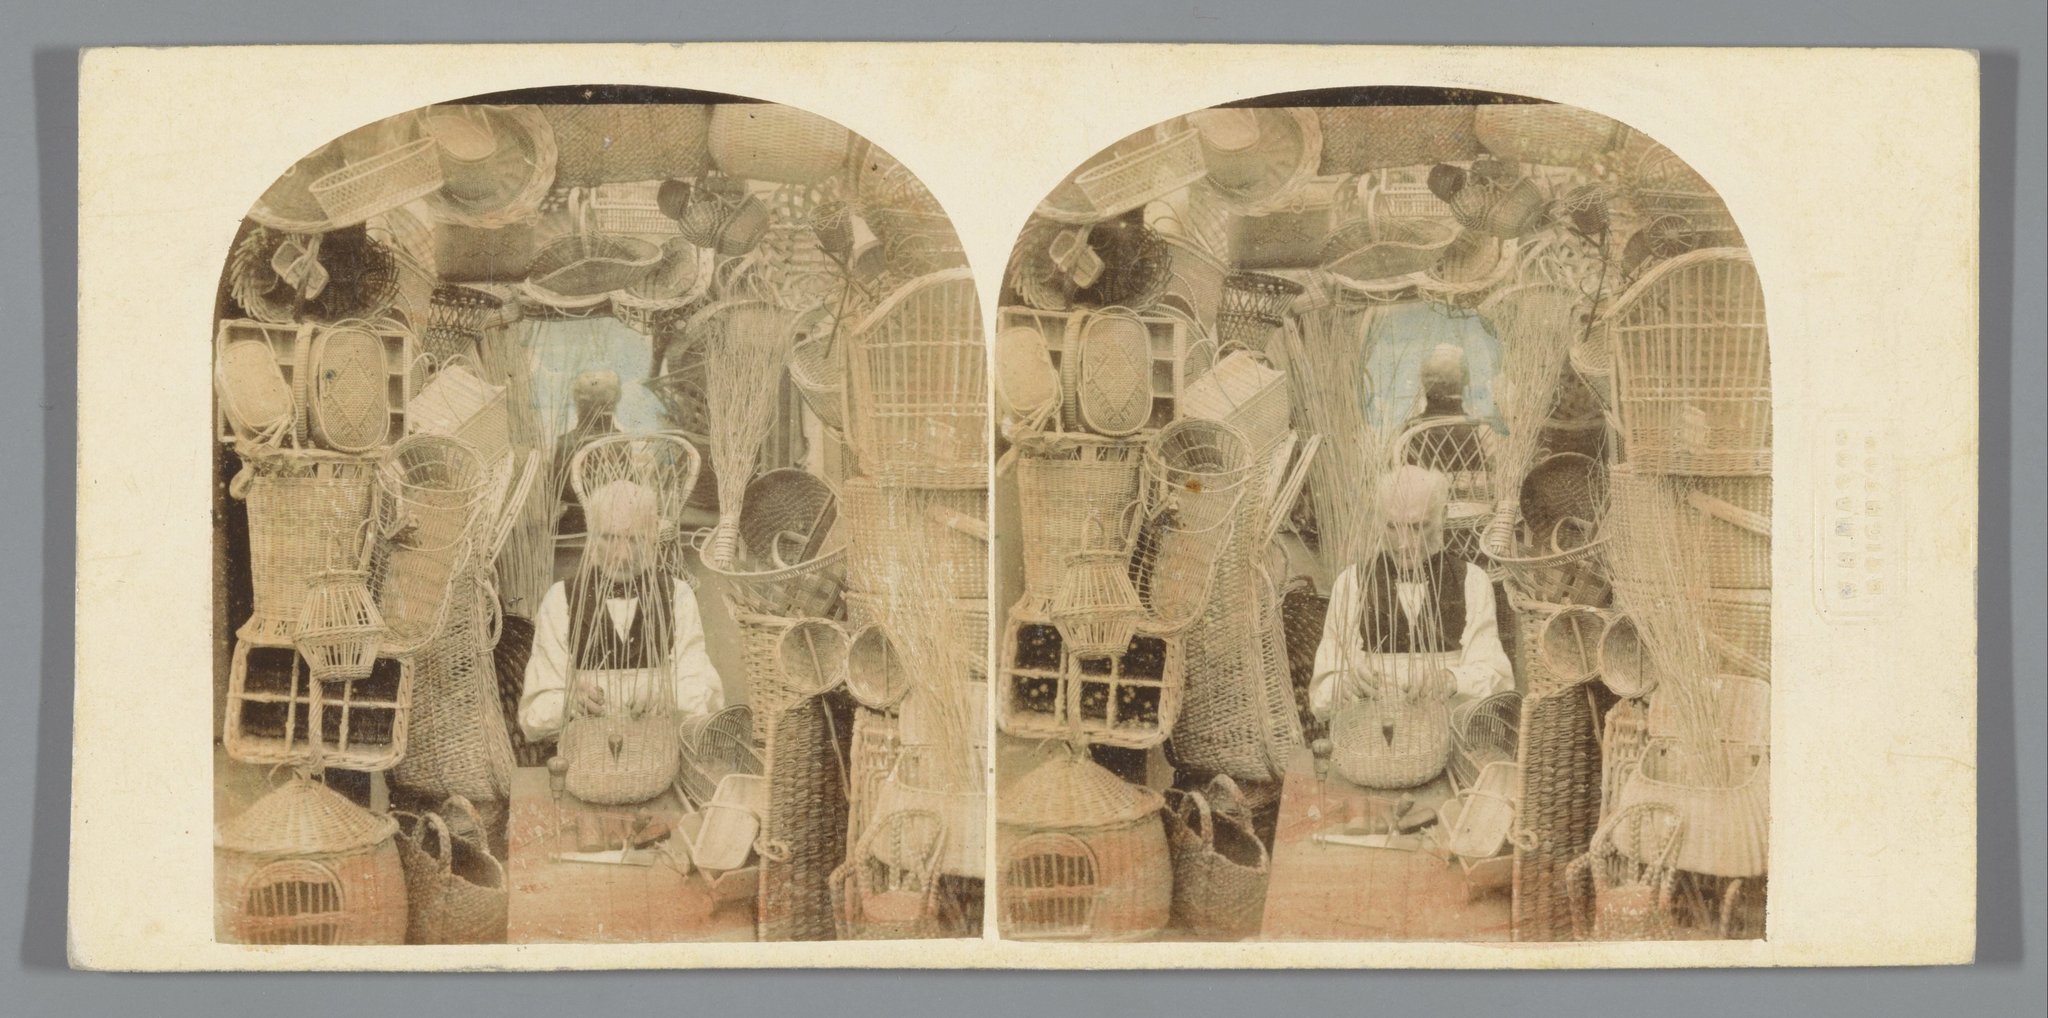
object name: stereograph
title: Mandenmaker vlecht een mand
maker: william henry mason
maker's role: fotograaf, prentverkoper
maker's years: 1810-1879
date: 1852-1863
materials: cardboard, paper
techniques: albumen print, hand coloring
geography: brighton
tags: craft-production, skilled handiwork, container made of plant material other than wood: basket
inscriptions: retailer's mark: ‘D. WAKKER/ Kalverstraat/ bij de Heiligenweg D.133’, inscription: ‘715’